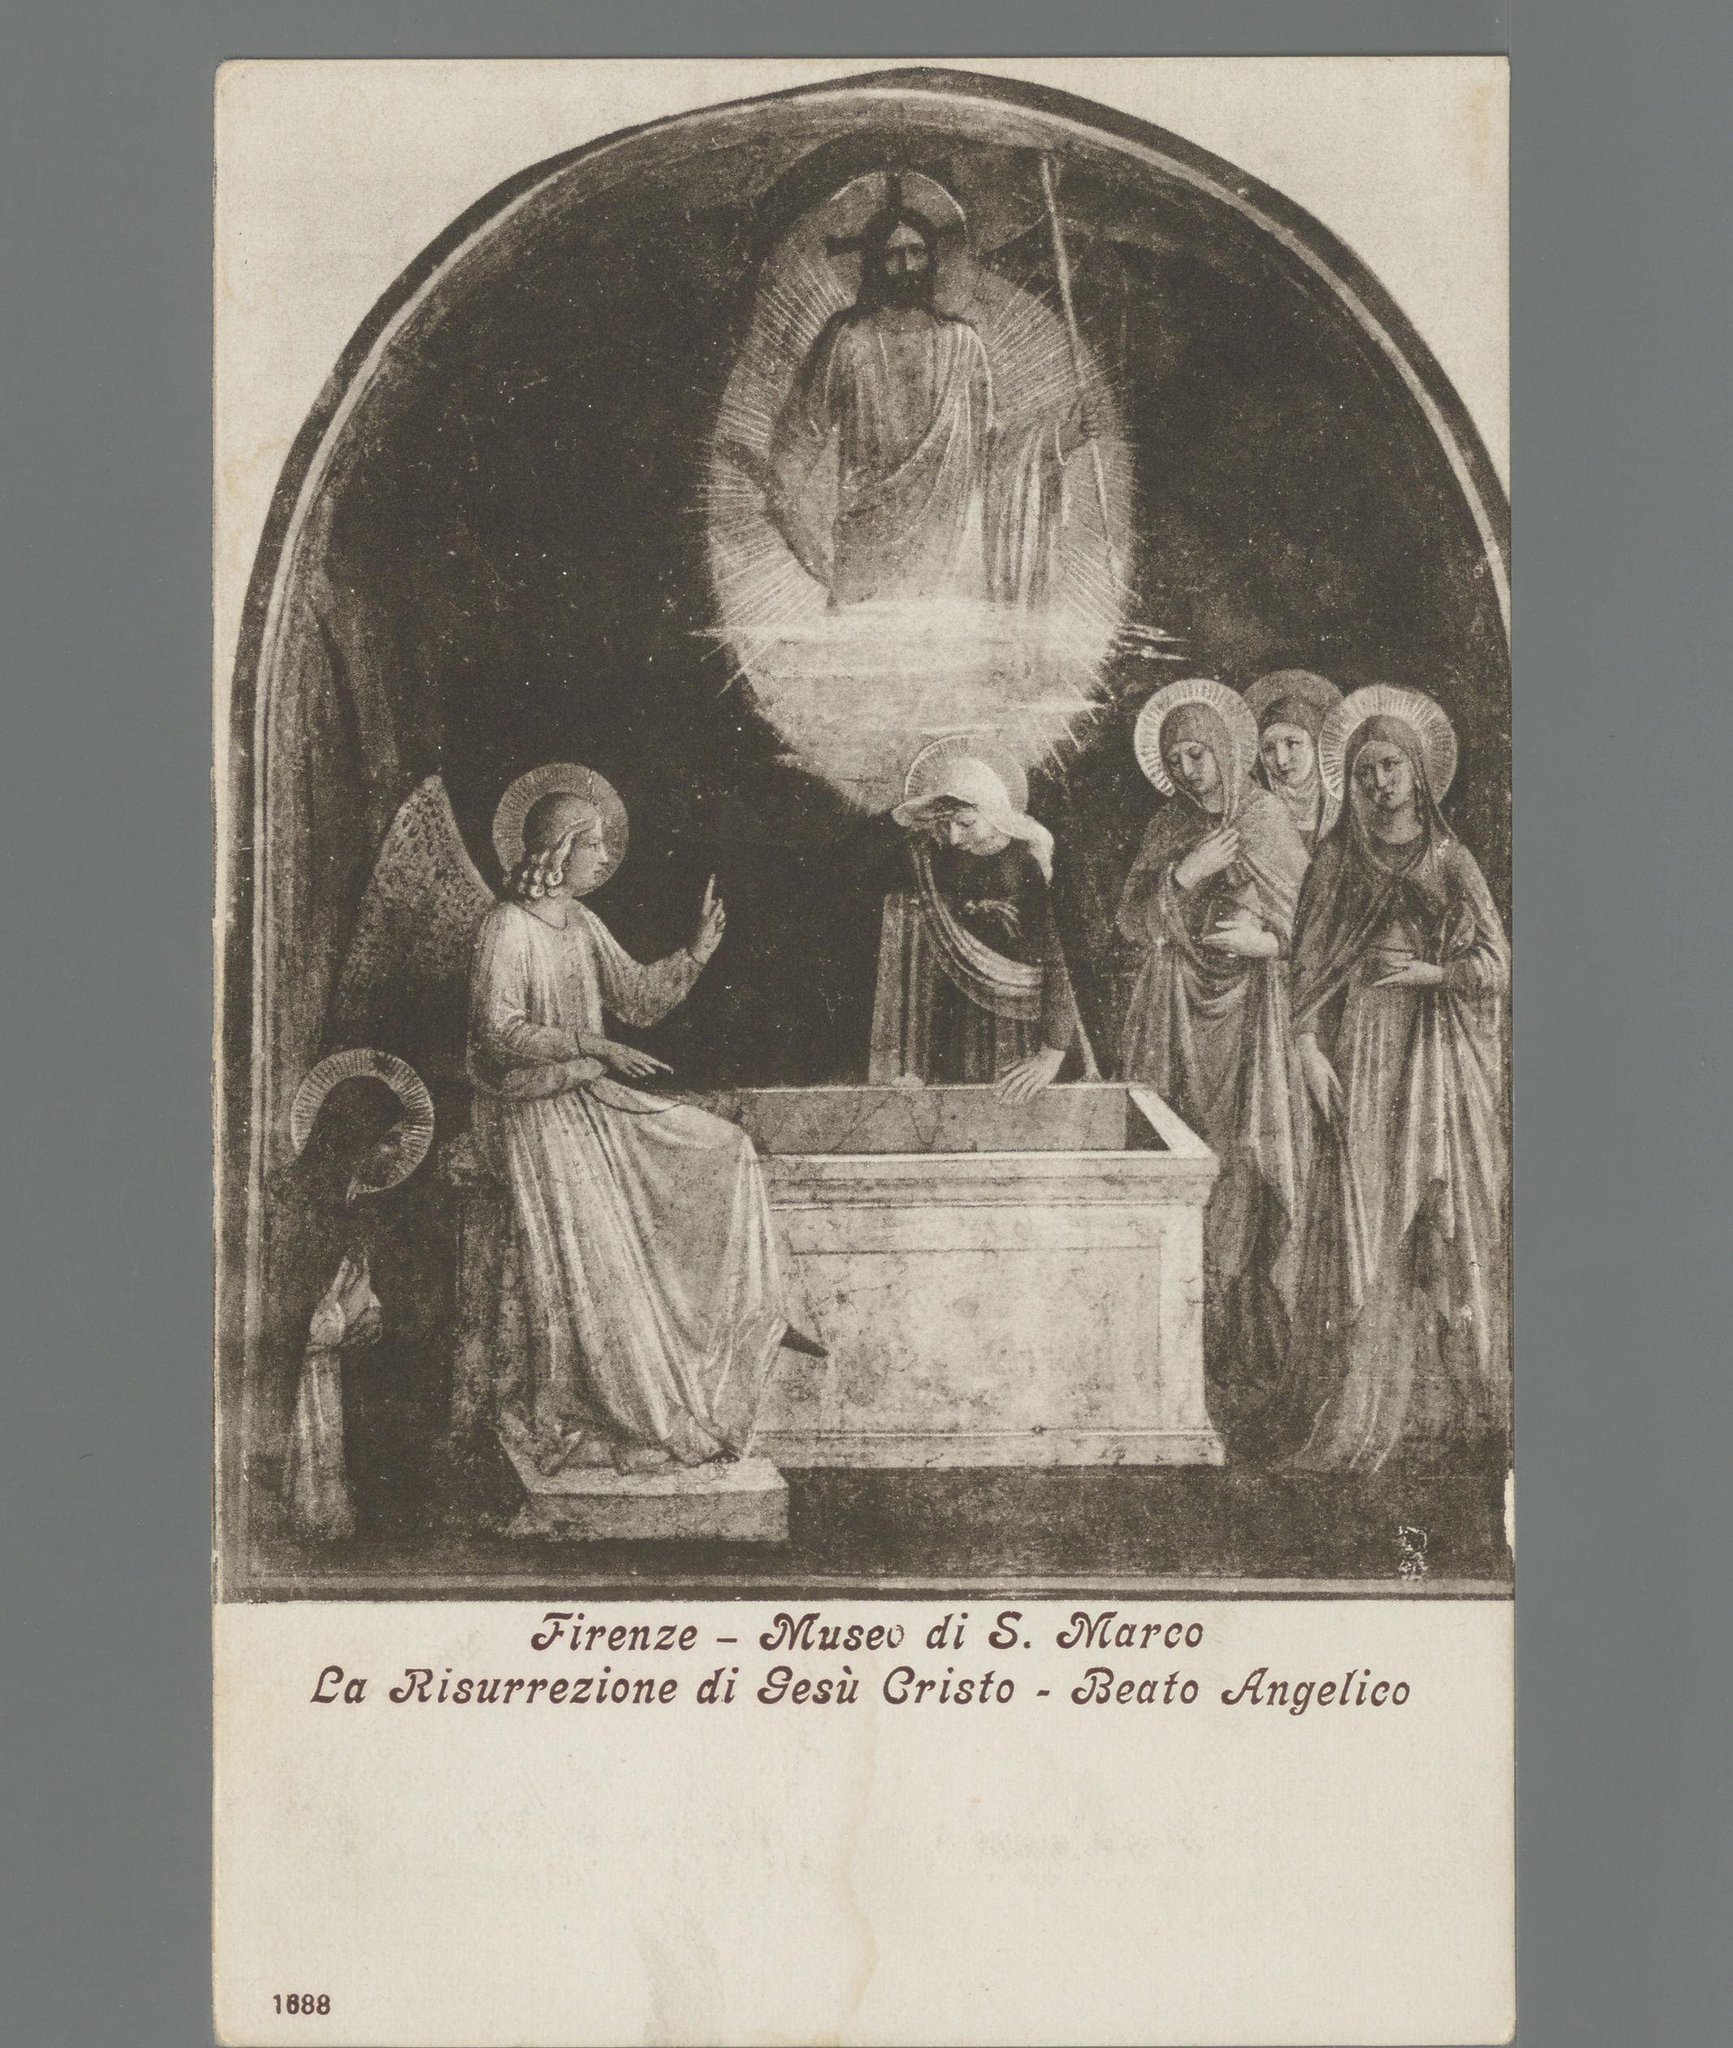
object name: reproduction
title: Firenze - Museo di S. Marco. La Risurrezione di Gesù Cristo - Beato Angelico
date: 1906-1930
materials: cardboard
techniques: photograph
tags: permanent exhibition, museum, picture, painting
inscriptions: monogram, collector's mark: ‘AFE v S’